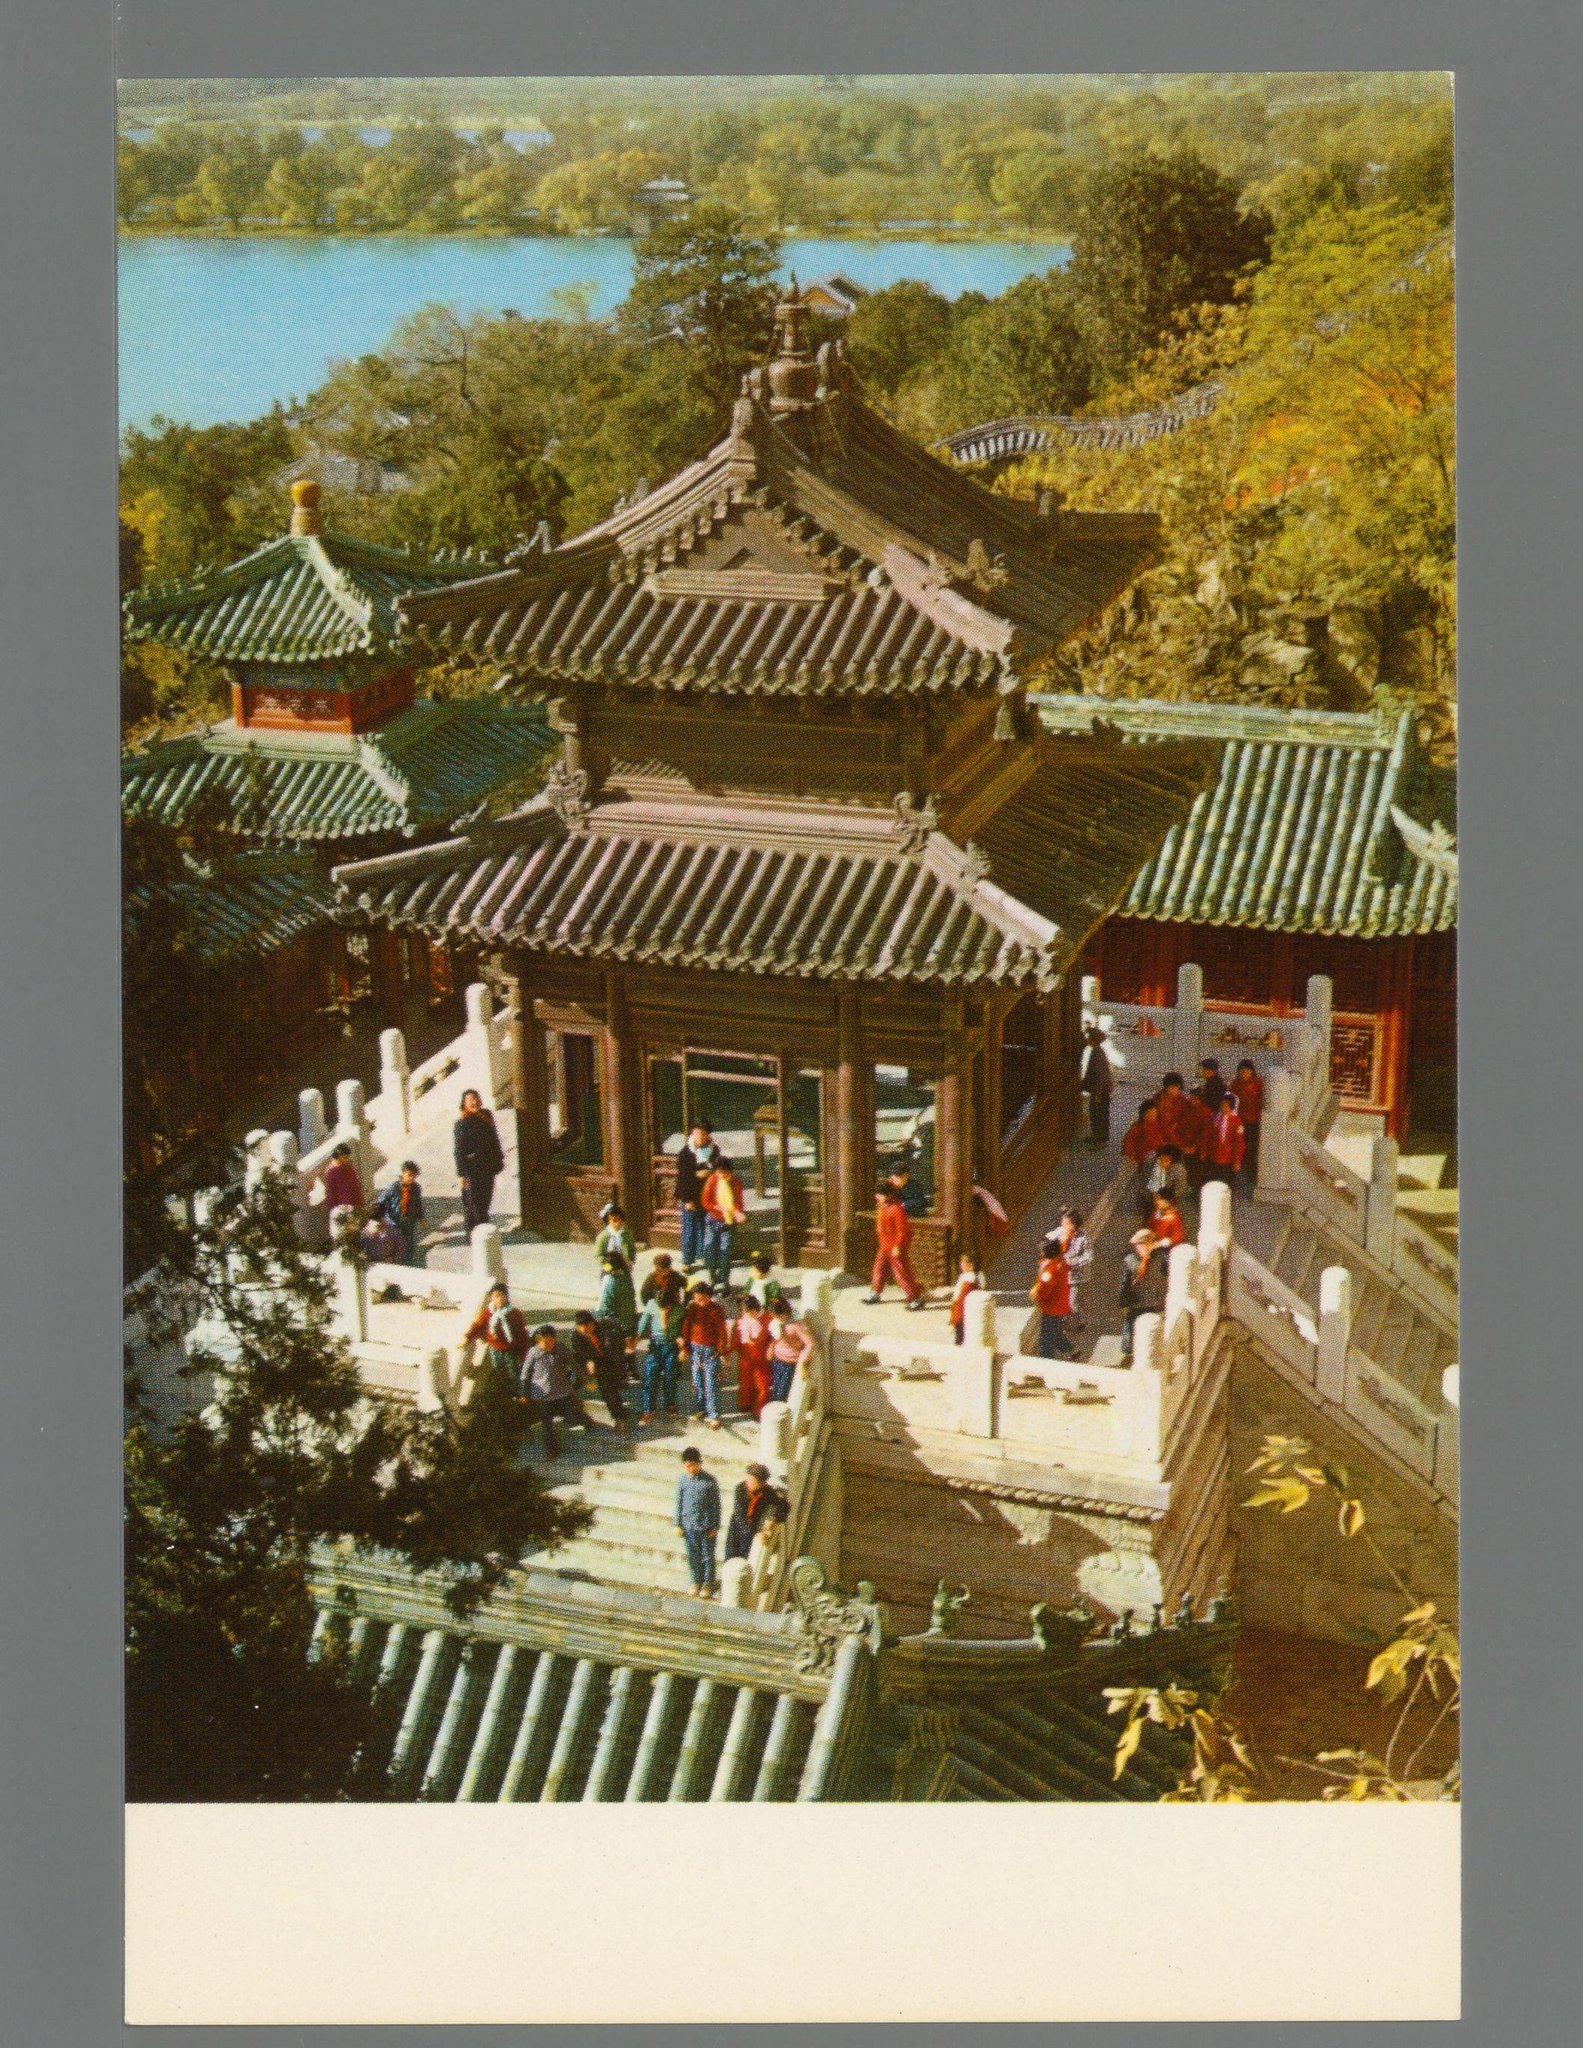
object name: photomechanical print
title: The Summer Palace, Peking / Vues du Palais d'Eté de Pékin / Vista del Palacio de Verano, Pekin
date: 1974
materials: cardboard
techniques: offset printed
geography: beijing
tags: palace, lake, bridge